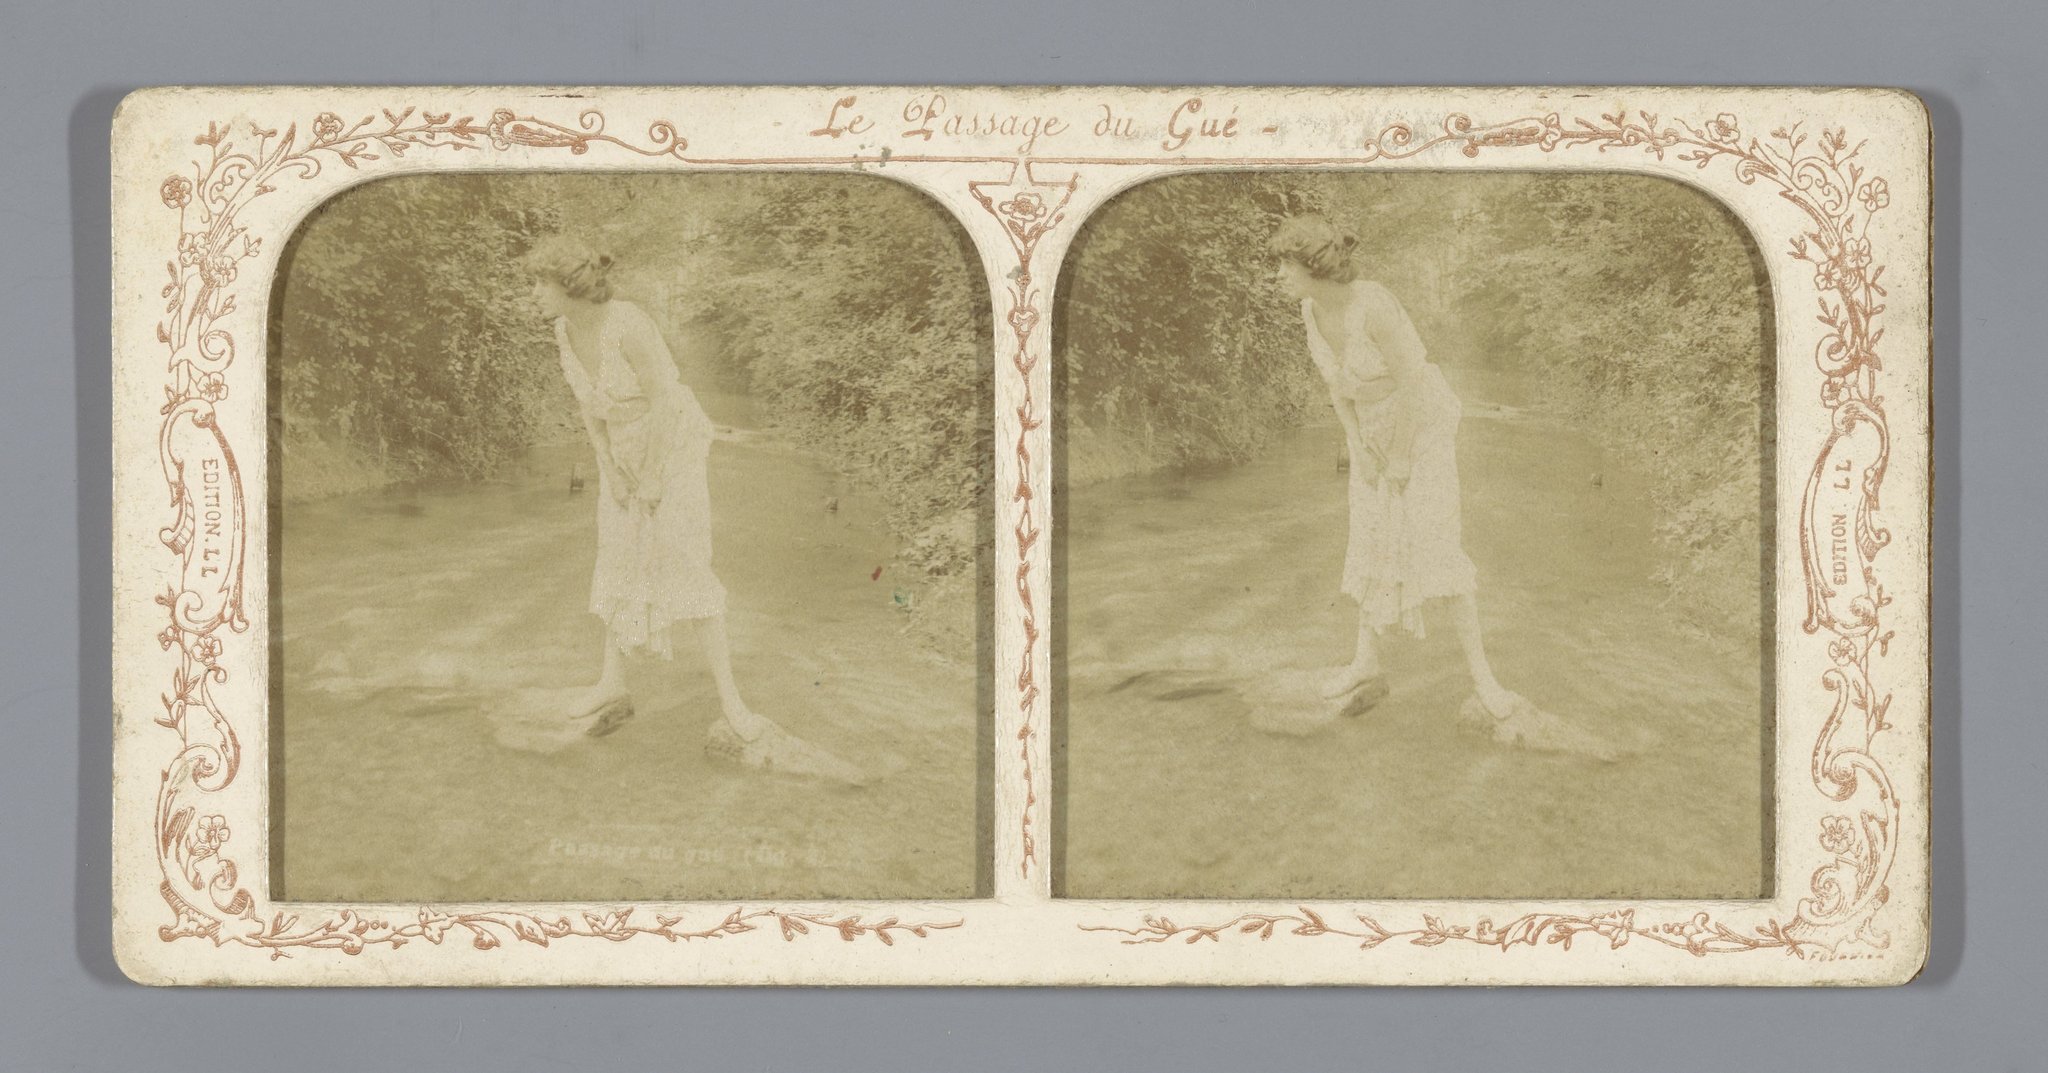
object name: tissue stereograph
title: Vrouw staande op enkele keien in een beek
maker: Anonymous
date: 1858-1875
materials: cardboard, paper, photographic support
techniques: albumen print, hand coloring, perforating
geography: paris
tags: adult woman, brook, france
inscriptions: number: ‘(fig. 4) [?]’